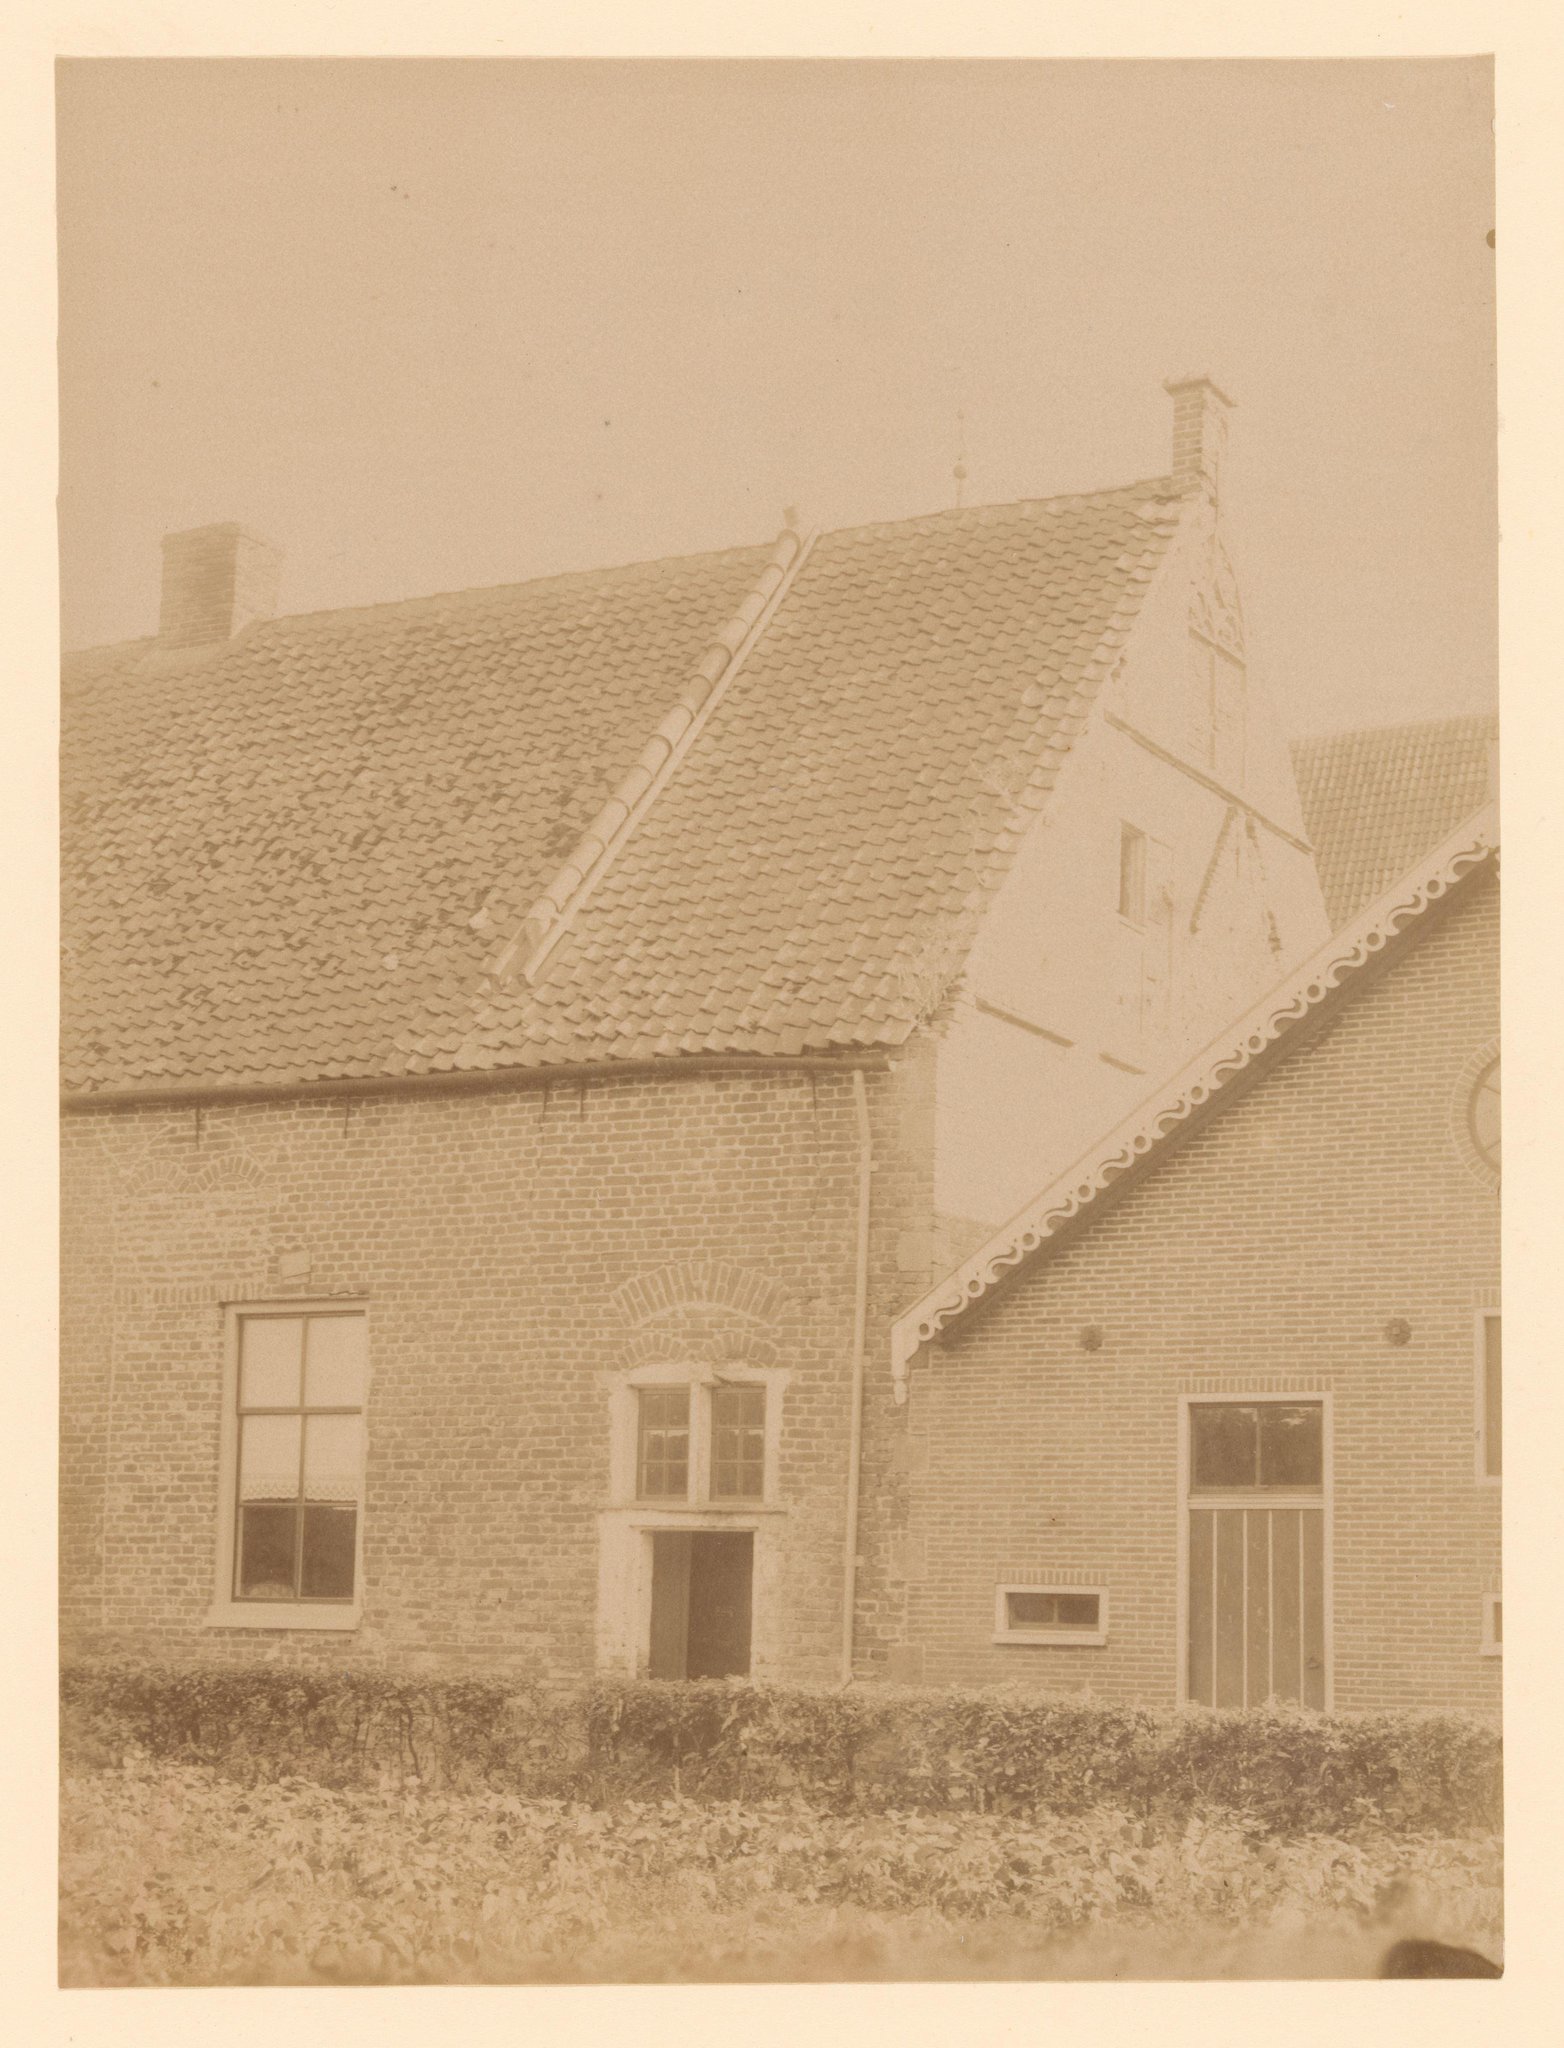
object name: photograph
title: Gedeelte van het Klooster Ter Apel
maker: anoniem (monumentenzorg)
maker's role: fotograaf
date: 1893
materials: cardboard, photographic support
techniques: albumen print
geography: ter apel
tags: cloisters ~ monastery, façade (of house or building)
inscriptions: annotation: ‘Ter Apel/ Eindgevel van de noordvleugel van het klooster/ sept 1893’, annotation: ‘Ter Apel’